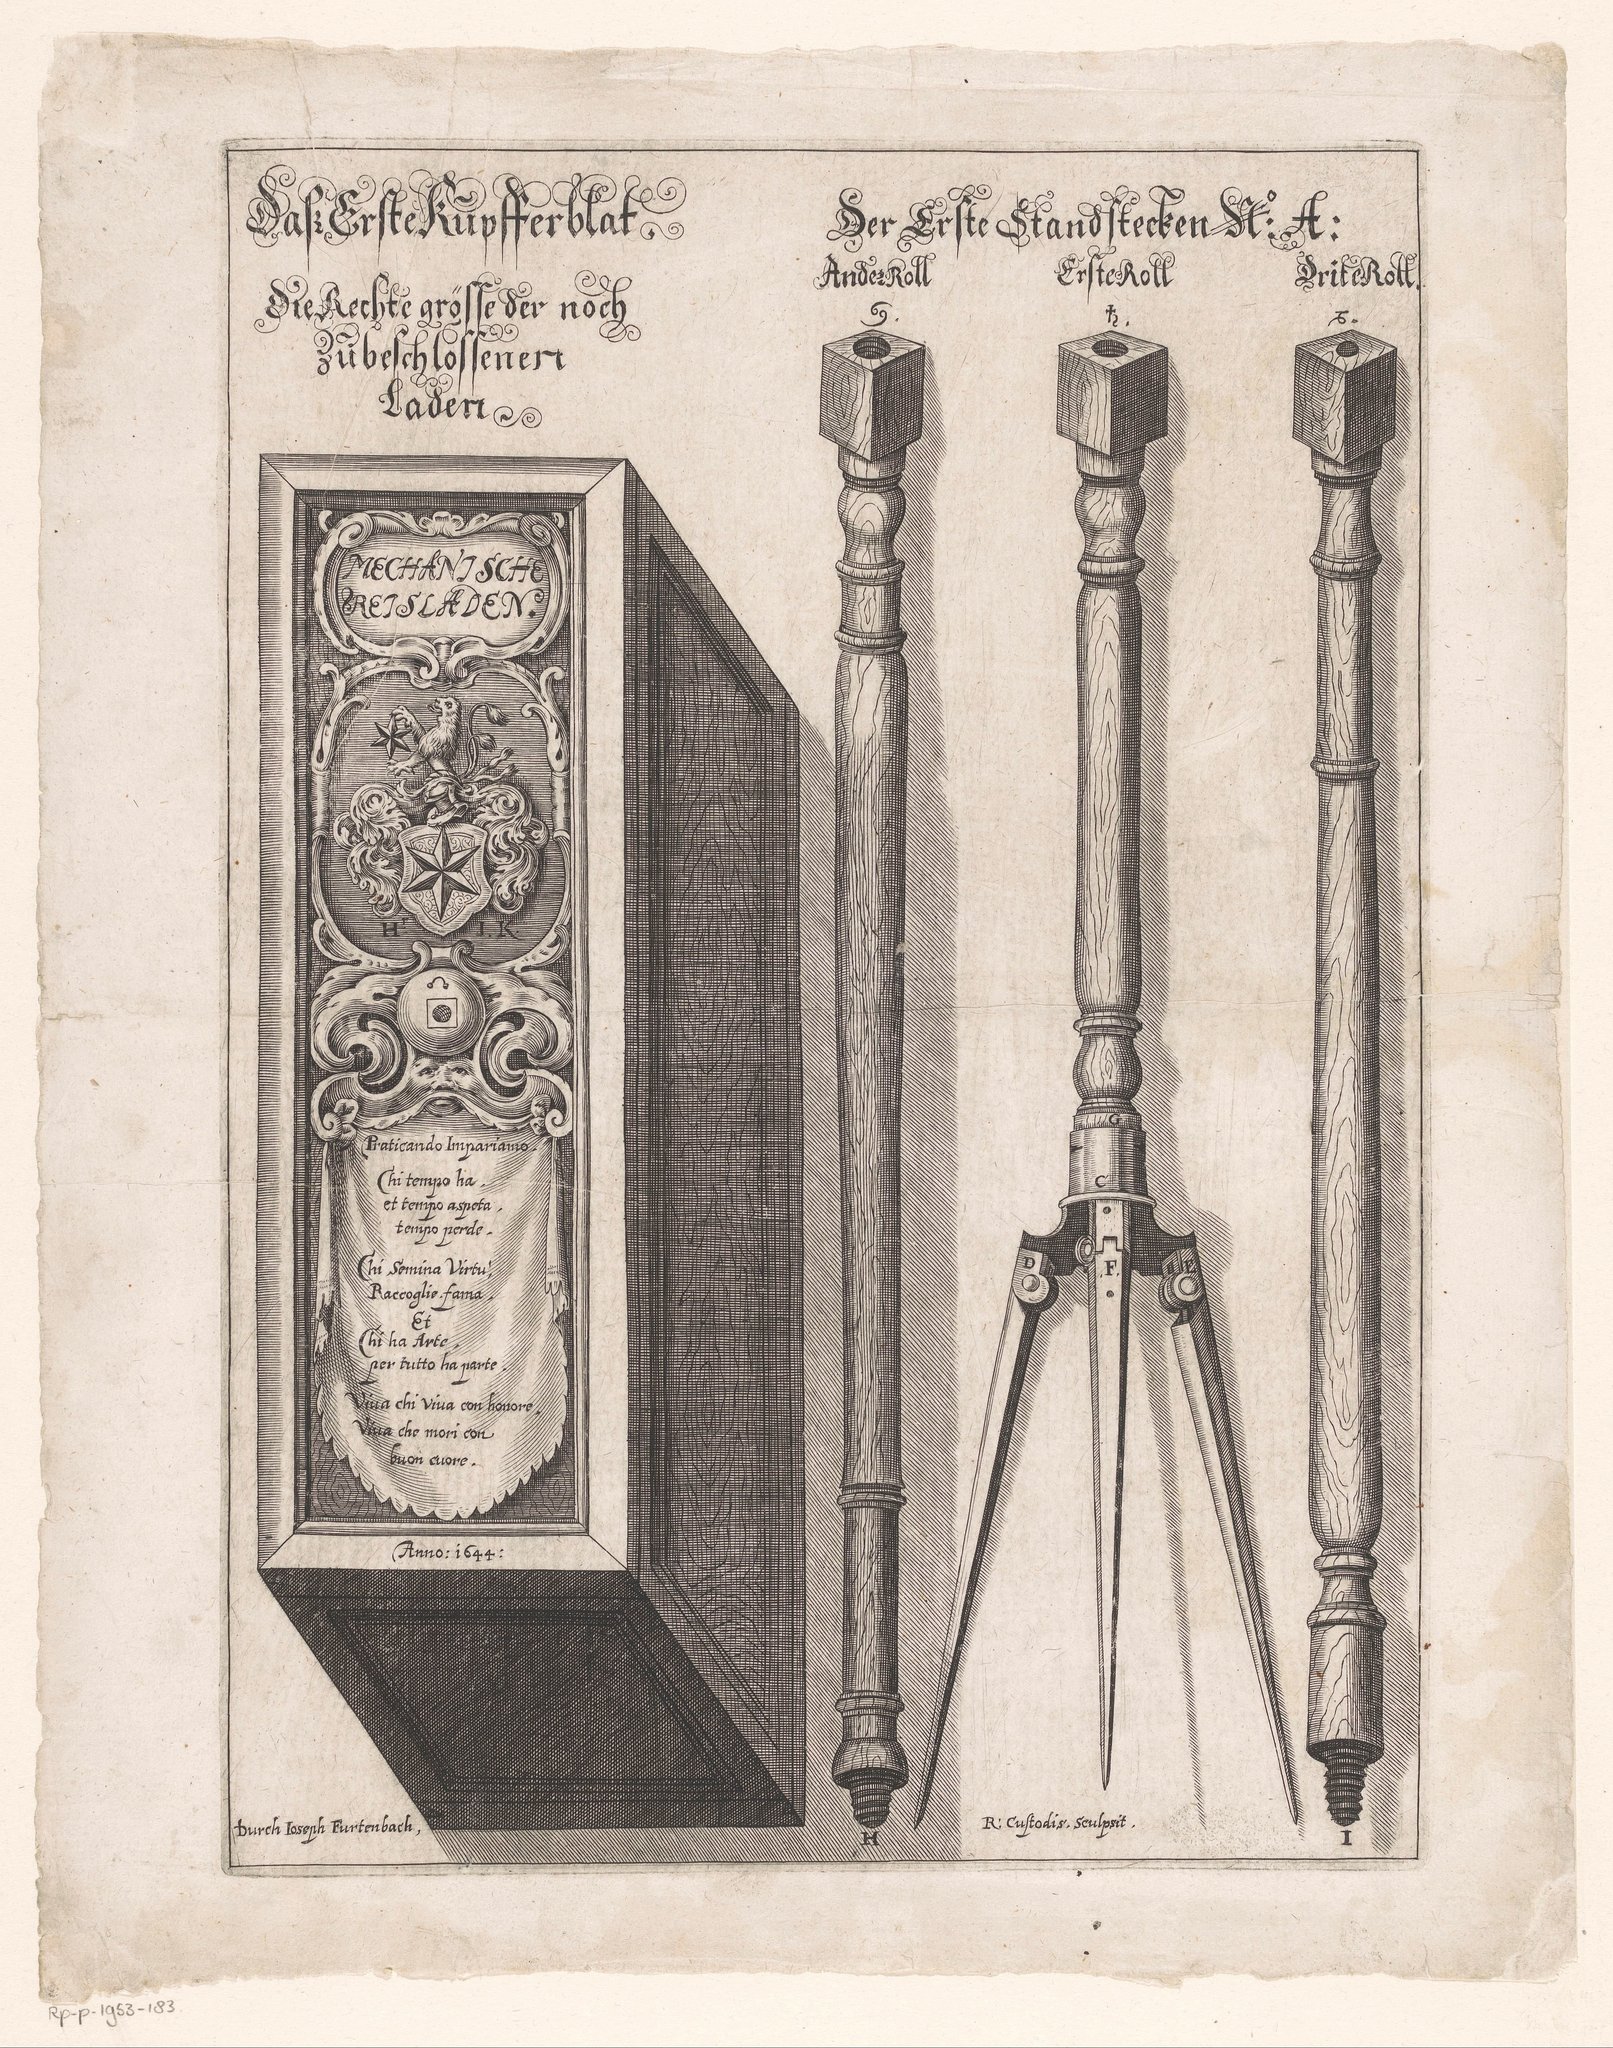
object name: print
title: Mechanische Reisladen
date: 1644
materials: paper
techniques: engraving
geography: augsburg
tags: luggage, travel requisites, mechanics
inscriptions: date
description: Prent uit: Furttenbach, Joseph. Mechanische ReißLaden, Das ist, Ein gar geschmeidige, bey sich verborgen tragende Laden. Augsburg: Schultes, 1644. Dit is de eerste van vier prenten die het ontwerp en de inhoud van het reiskastje tonen.